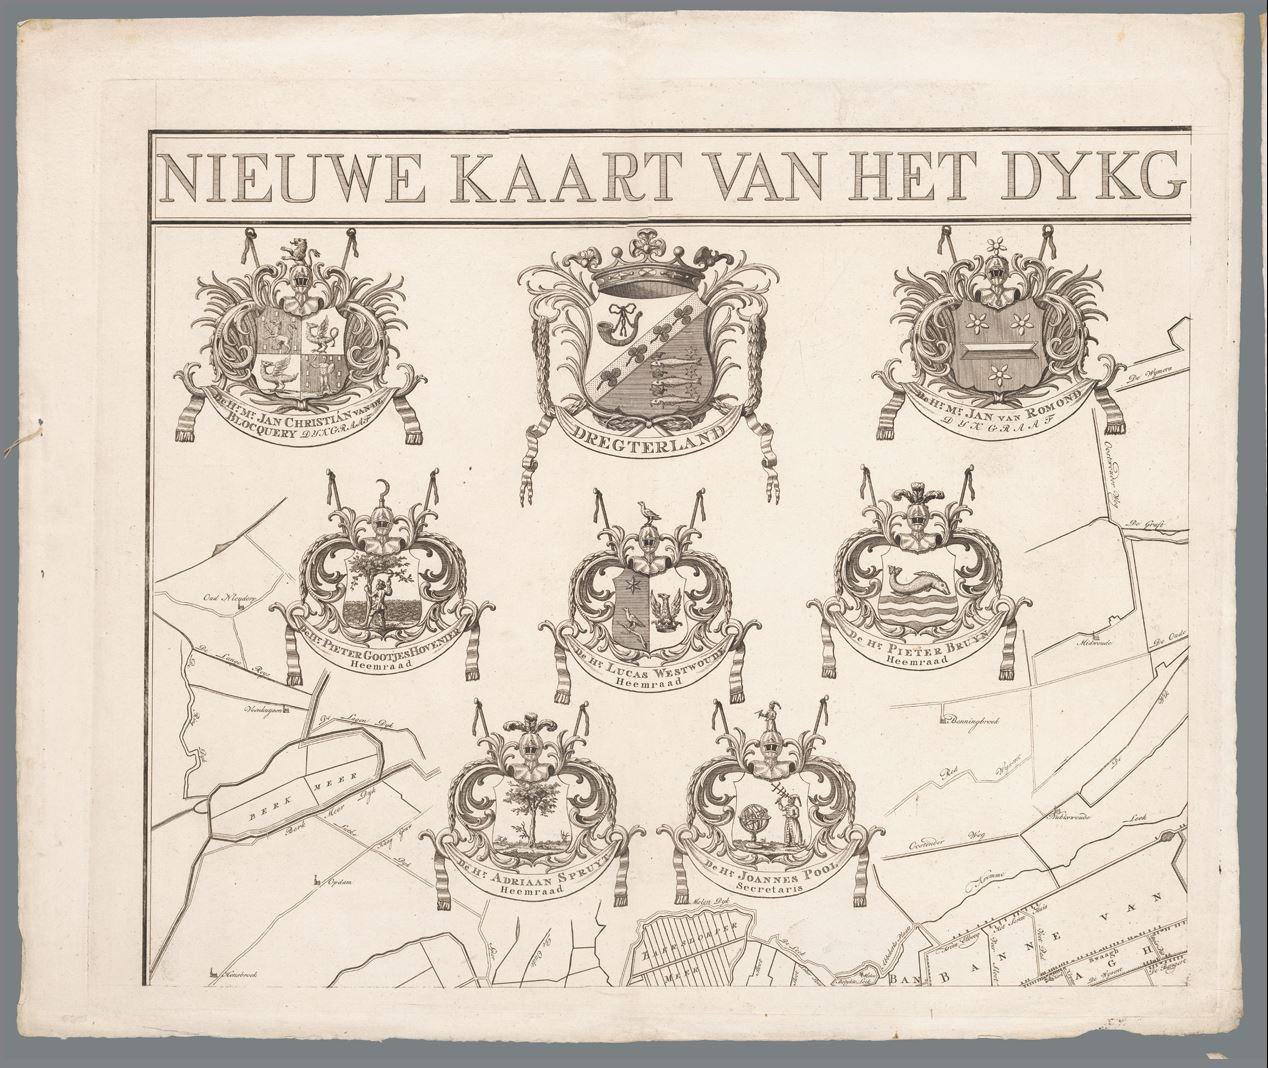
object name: map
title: Nieuwe kaart van het dykgraafschap van Dregterland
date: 1775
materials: paper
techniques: engraving, etching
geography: amsterdam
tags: coat of arms (as symbol of the state, etc.), maps of separate countries or regions, polder, reclaimed land, armorial bearing, heraldry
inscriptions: date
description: Deel (linksboven) van een kaart van het dijkgraafschap Drechterland.